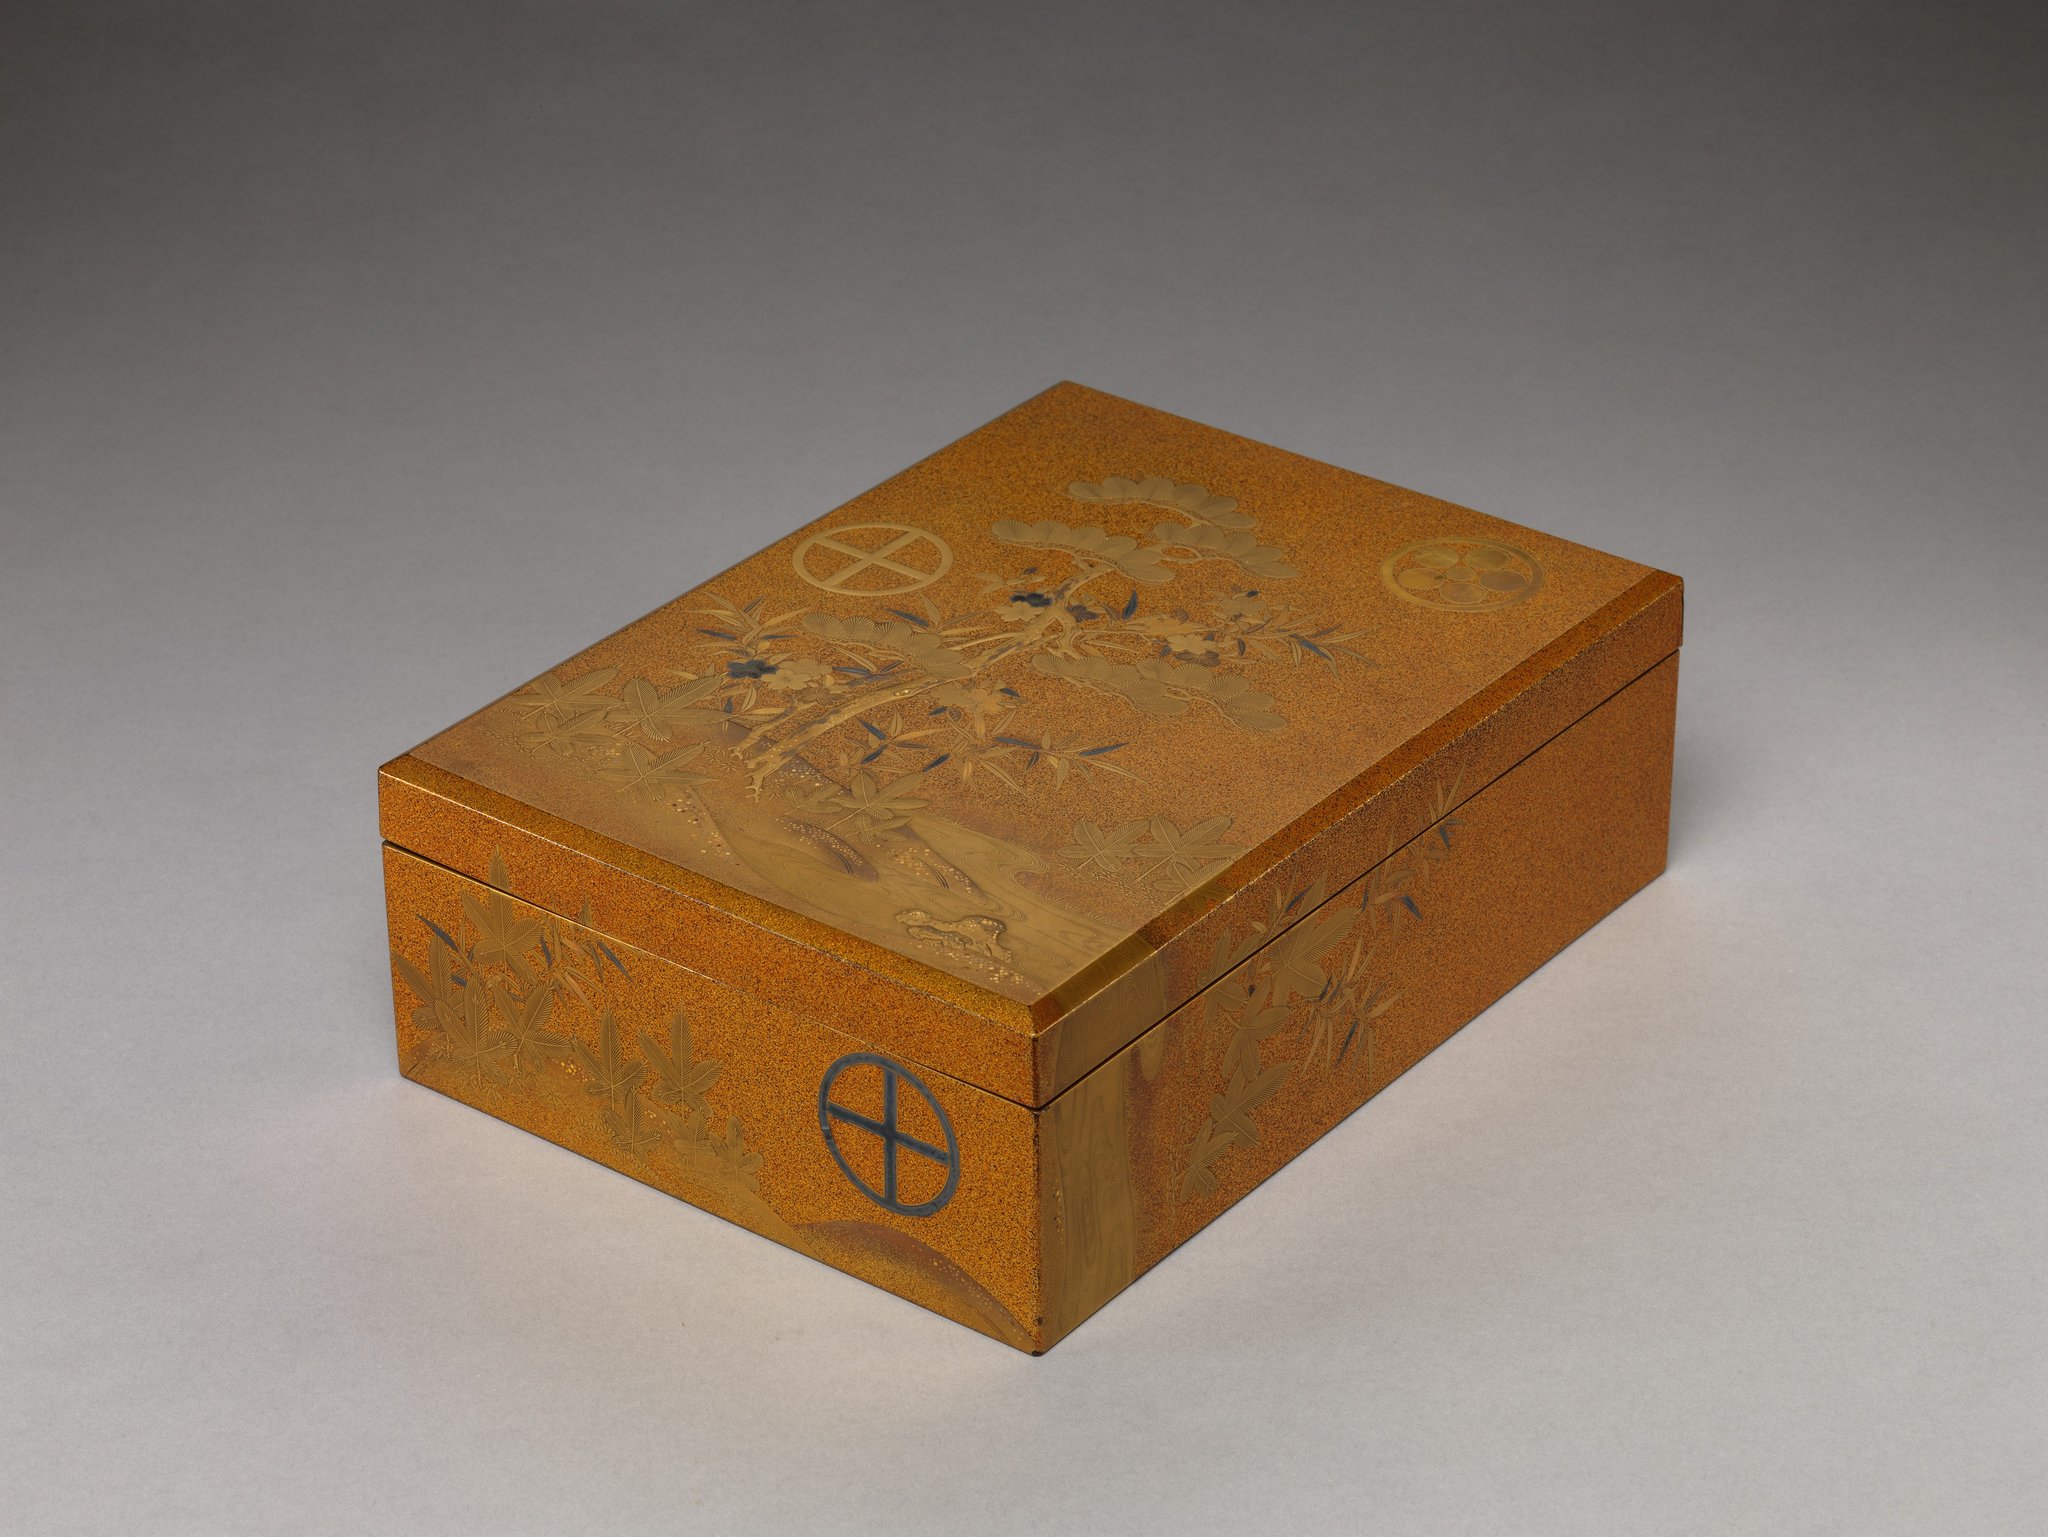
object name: box with cover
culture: japanese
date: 1801-1900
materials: gold, lacquer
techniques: maki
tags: trees